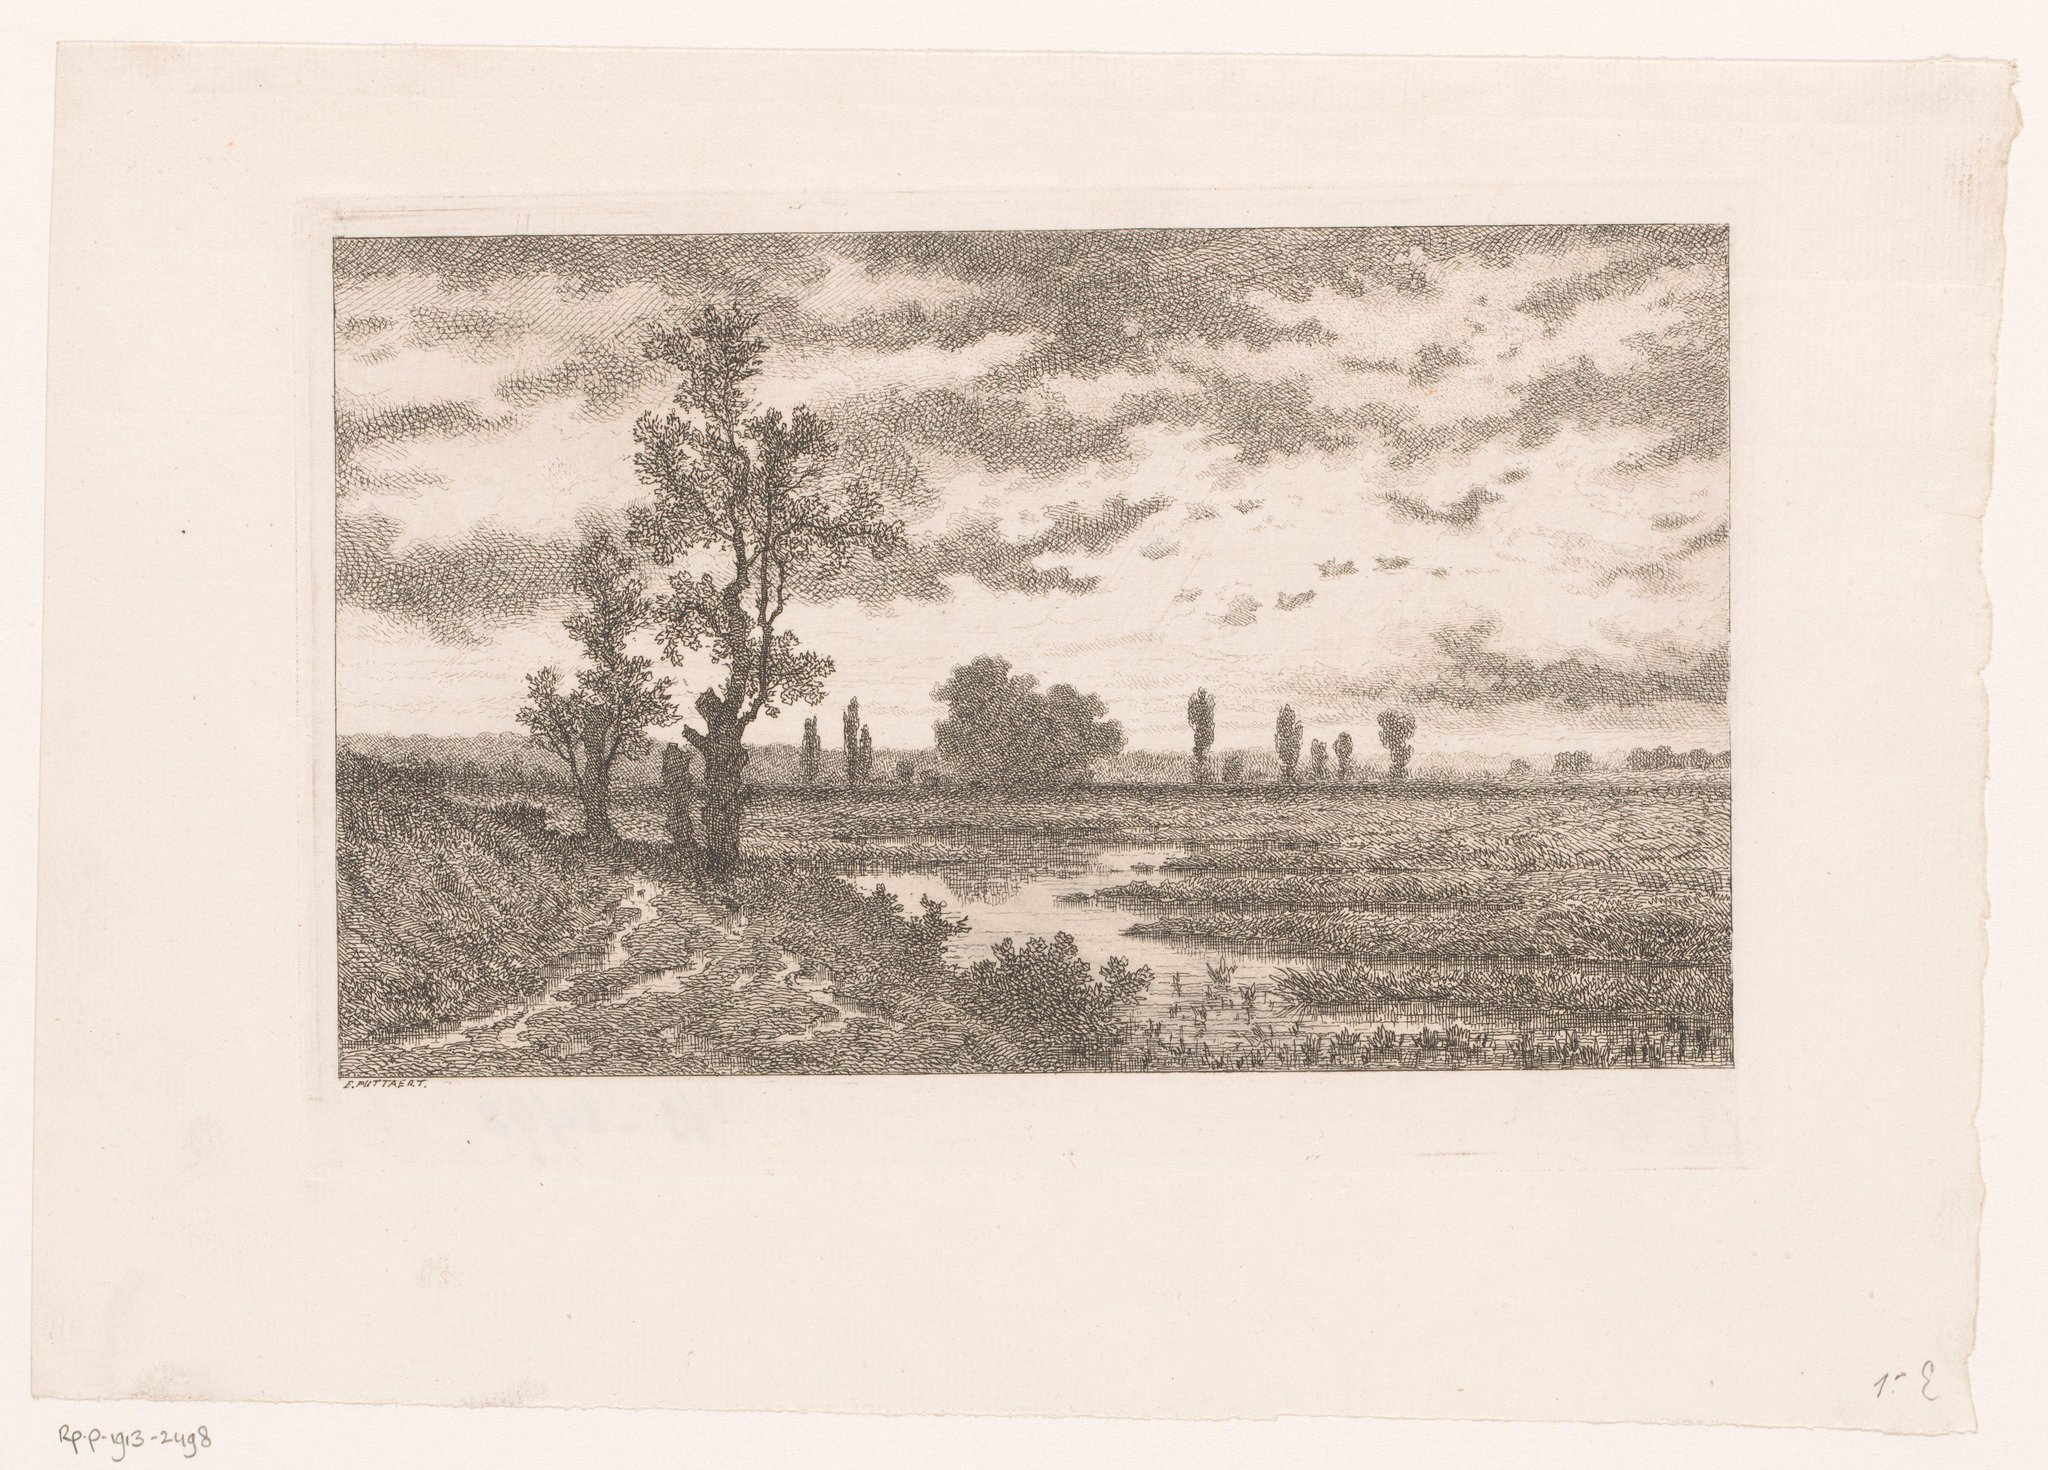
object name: print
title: Gezicht op de Leie nabij Gent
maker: emile puttaert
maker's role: print maker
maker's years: 1829-1901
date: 1875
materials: paper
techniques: etching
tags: landscapes with waters, waterscapes, seascapes (in the temperate zone)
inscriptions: collector's mark: Lugt 2228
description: Latere staat verschenen onder de titel 'd'apres orage' in: Rops, Félicien (red.). Cahier d'études: eaux-fortes originales et inédites. Brussel: Felix Callewaert père, 1875.